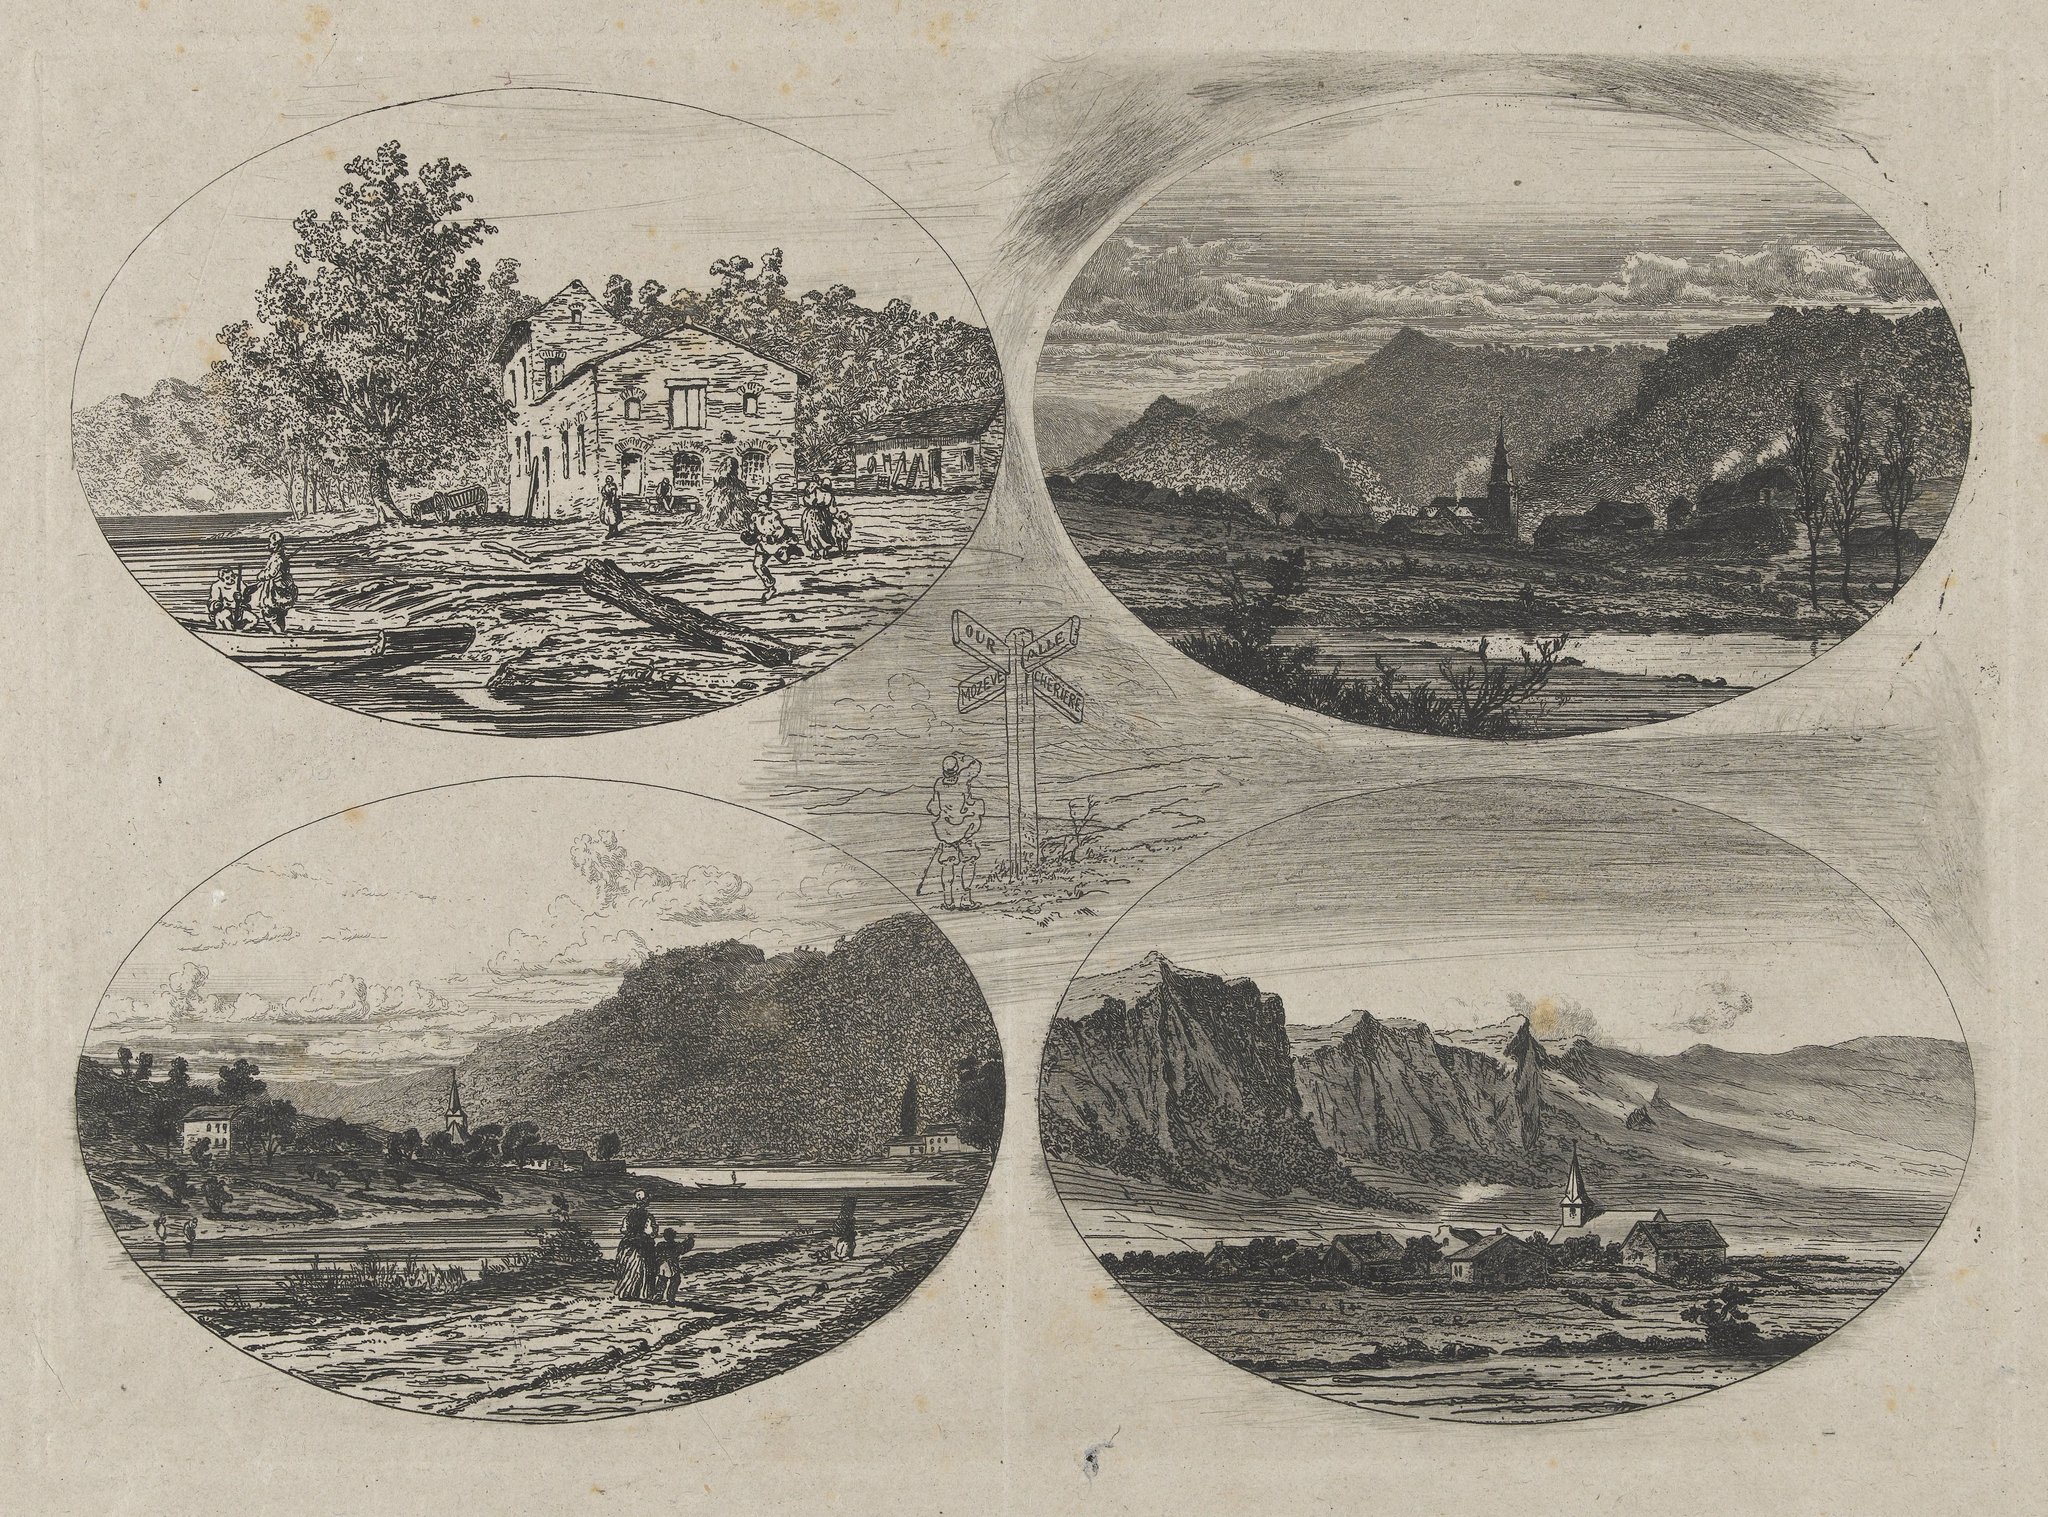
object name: print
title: Our, Alle, Mozéve, Cherière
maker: martinus antonius kuytenbrouwer jr.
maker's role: draughtsman, painter, print maker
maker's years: 1821-1897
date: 1831-1897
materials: paper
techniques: drypoint, etching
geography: netherlands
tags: prospect of village, silhouette of village, river, village, church (exterior), 'en route', traveller under way, mountains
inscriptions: collector's mark: Lugt 2228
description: Blad met vier medaillons met gezichten op Belgische dorpen. Linksboven een medaillon met een gezicht op het dorp Ouren aan de rivier de Our en rechtsboven het dorp Alle met de contouren van de Sint-Mauruskerk. Linksonder een medaillon met een gezicht op Mouzaive aan de rivier de Semois en rechtsonder het dorp Chairière en de Eglise Saint-Walfroid kerk. In het midden van de medaillons een viersprong, met de dorpsnamen. Bij de viersprong staat een wandelaar.